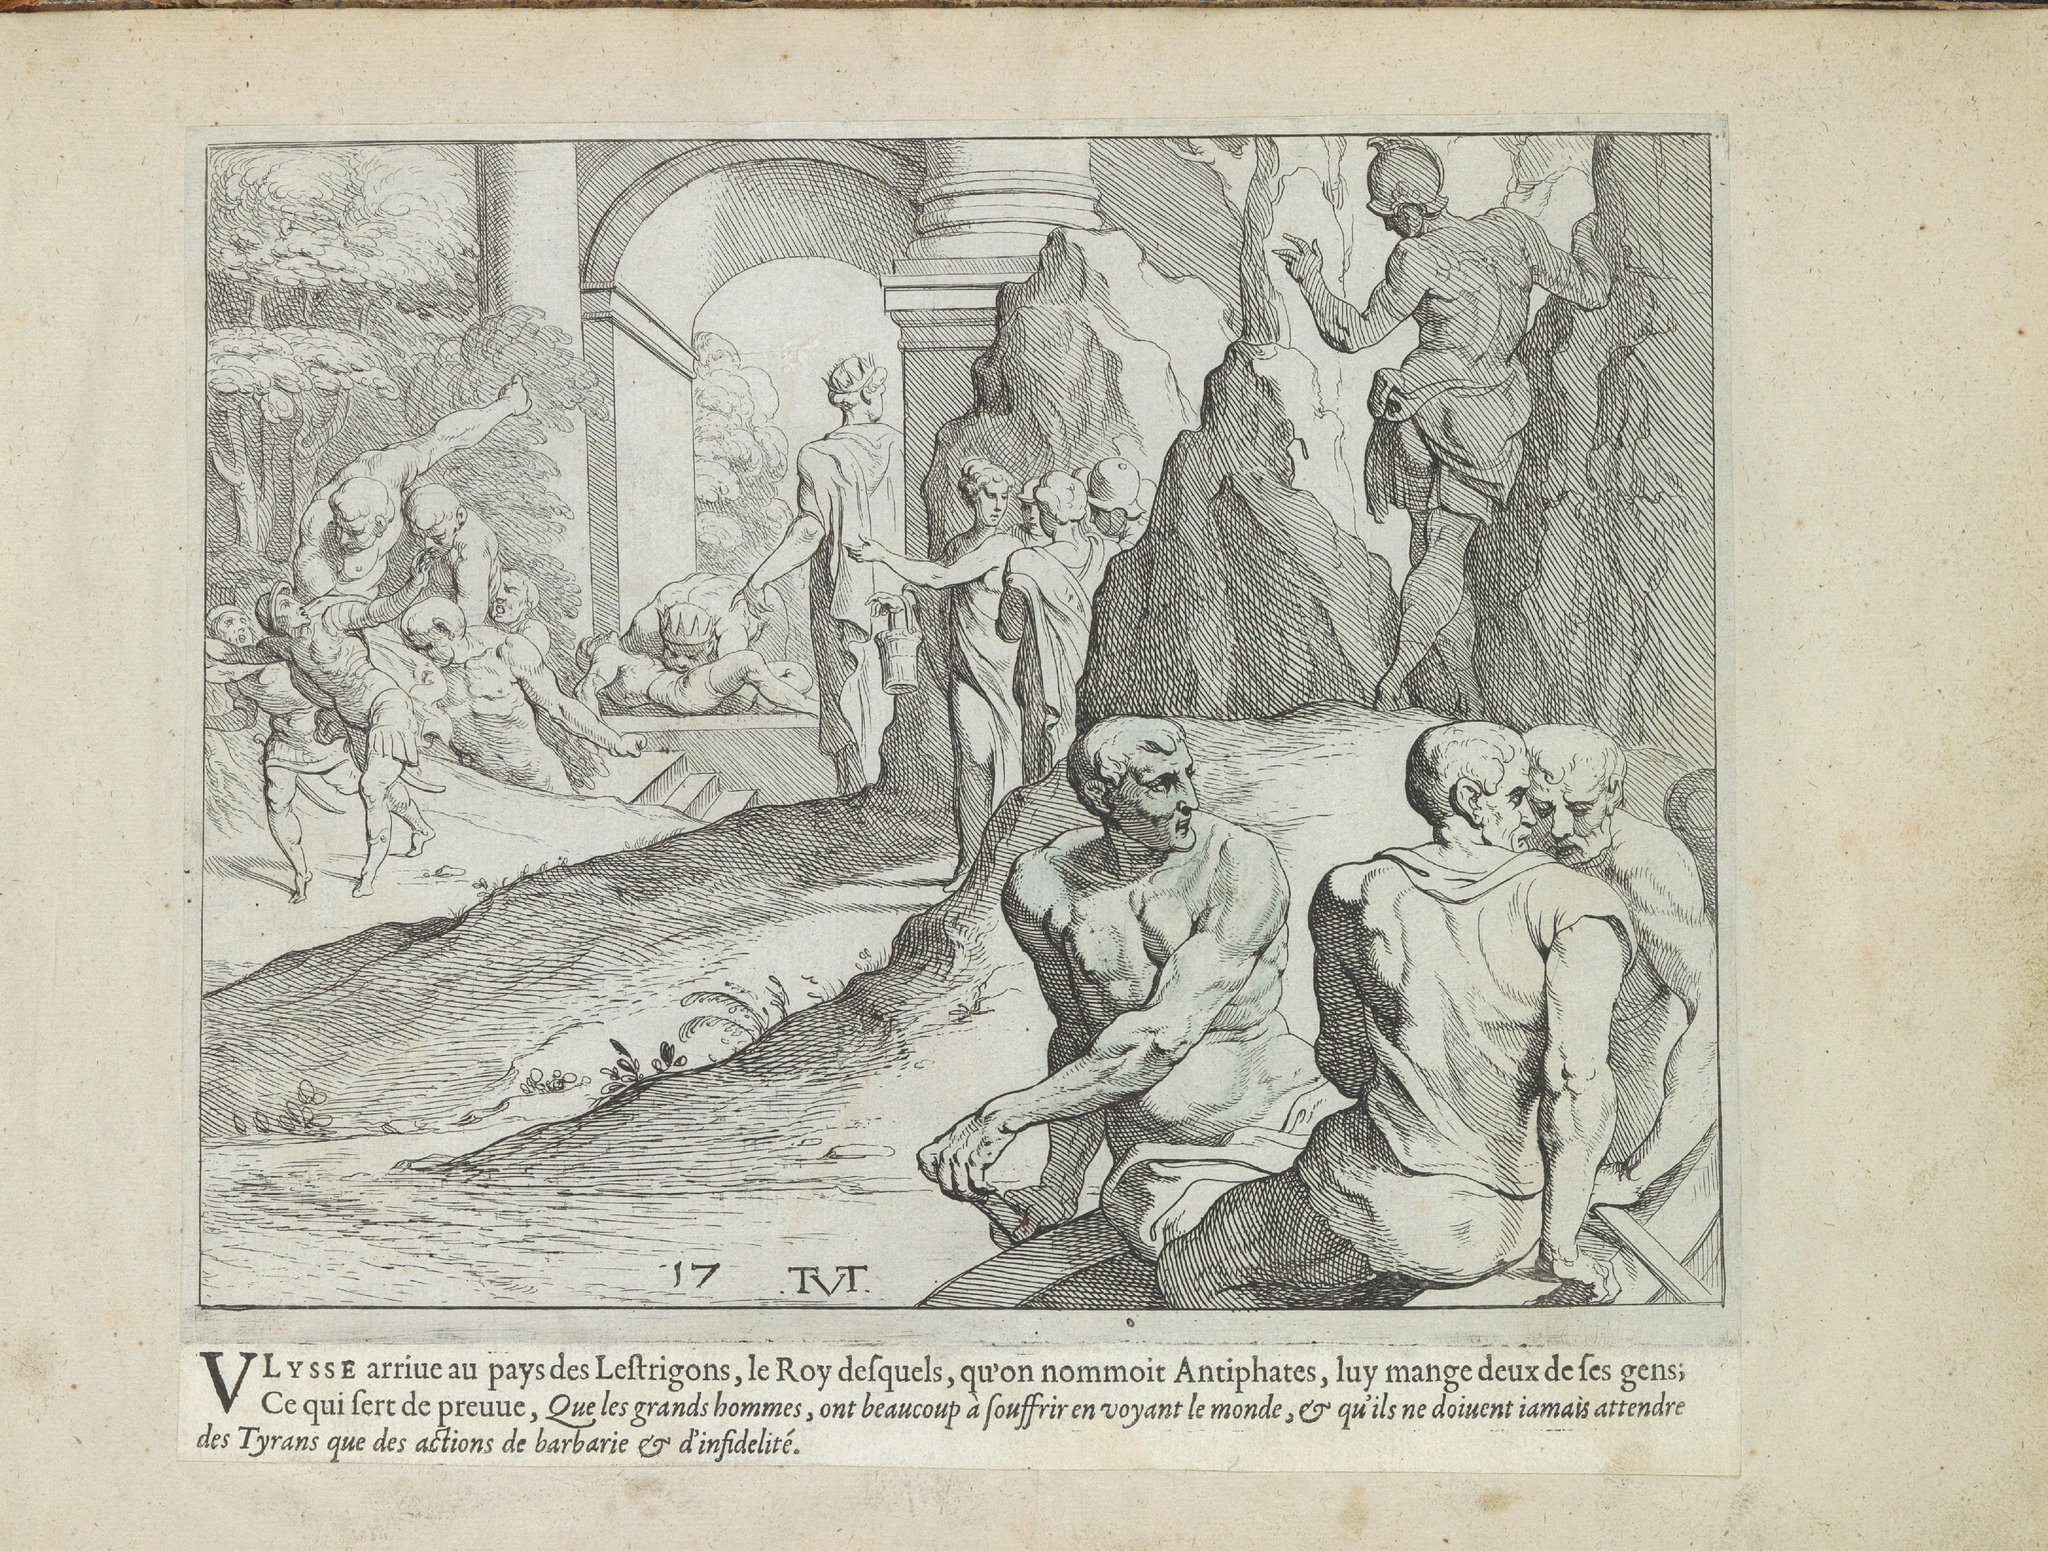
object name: print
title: Odysseus in het land van de Laistrygonen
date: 1633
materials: paper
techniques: engraving, etching, letterpress printing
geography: paris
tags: ulysses comes to the land of the laestrygones, the cannibal giants, who devour some of ulysses' comrades and destroy their ships (homer, odyssey x)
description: In het land van de Laistrygonen wordt een aantal van Odysseus' mannen opgegeten door de reuzen die er wonen. Op de voorgrond varen drie mannen weg van het eiland. De prent maakt deel uit van een album.